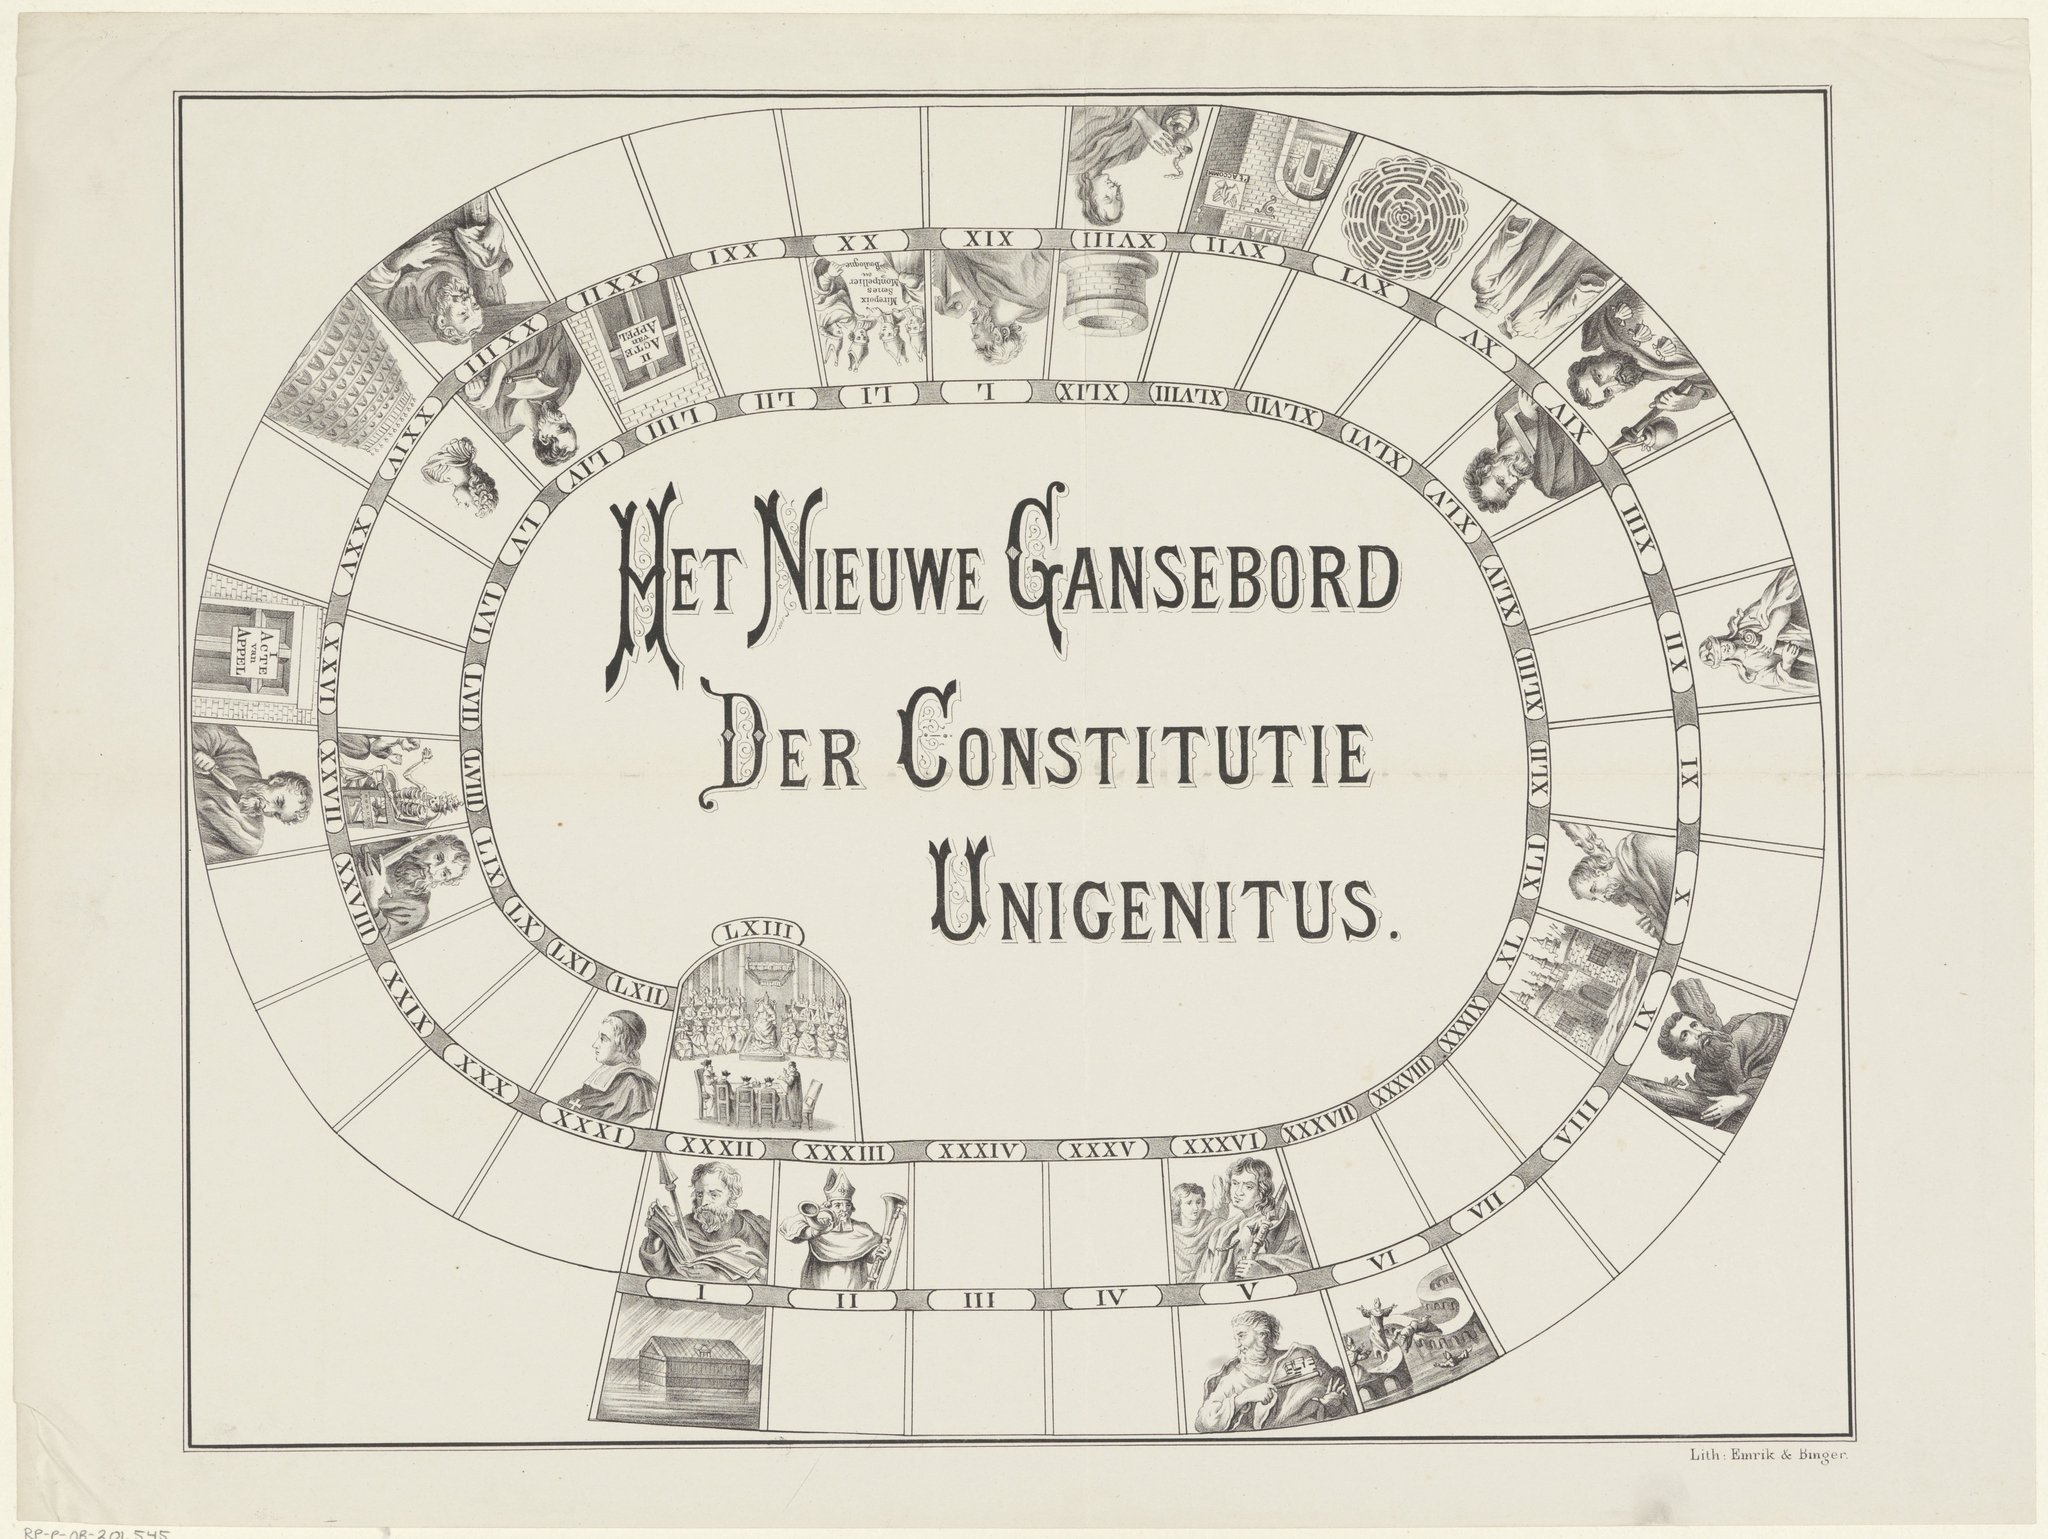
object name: gameboard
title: Het nieuwe gansebord / Der constitutie / Unigenitus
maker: Anonymous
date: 1880-1900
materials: paper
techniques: lithograph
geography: netherlands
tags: board-games of chance, saints, board-games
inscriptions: collector's mark: Lugt 2760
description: Bordspel met spiraal met vakjes genummerd van 1 tot en met 63. Op het middenveld de titel van het spel in sierletters. In verschillende vakjes afbeeldingen van heiligen en gebouwen.